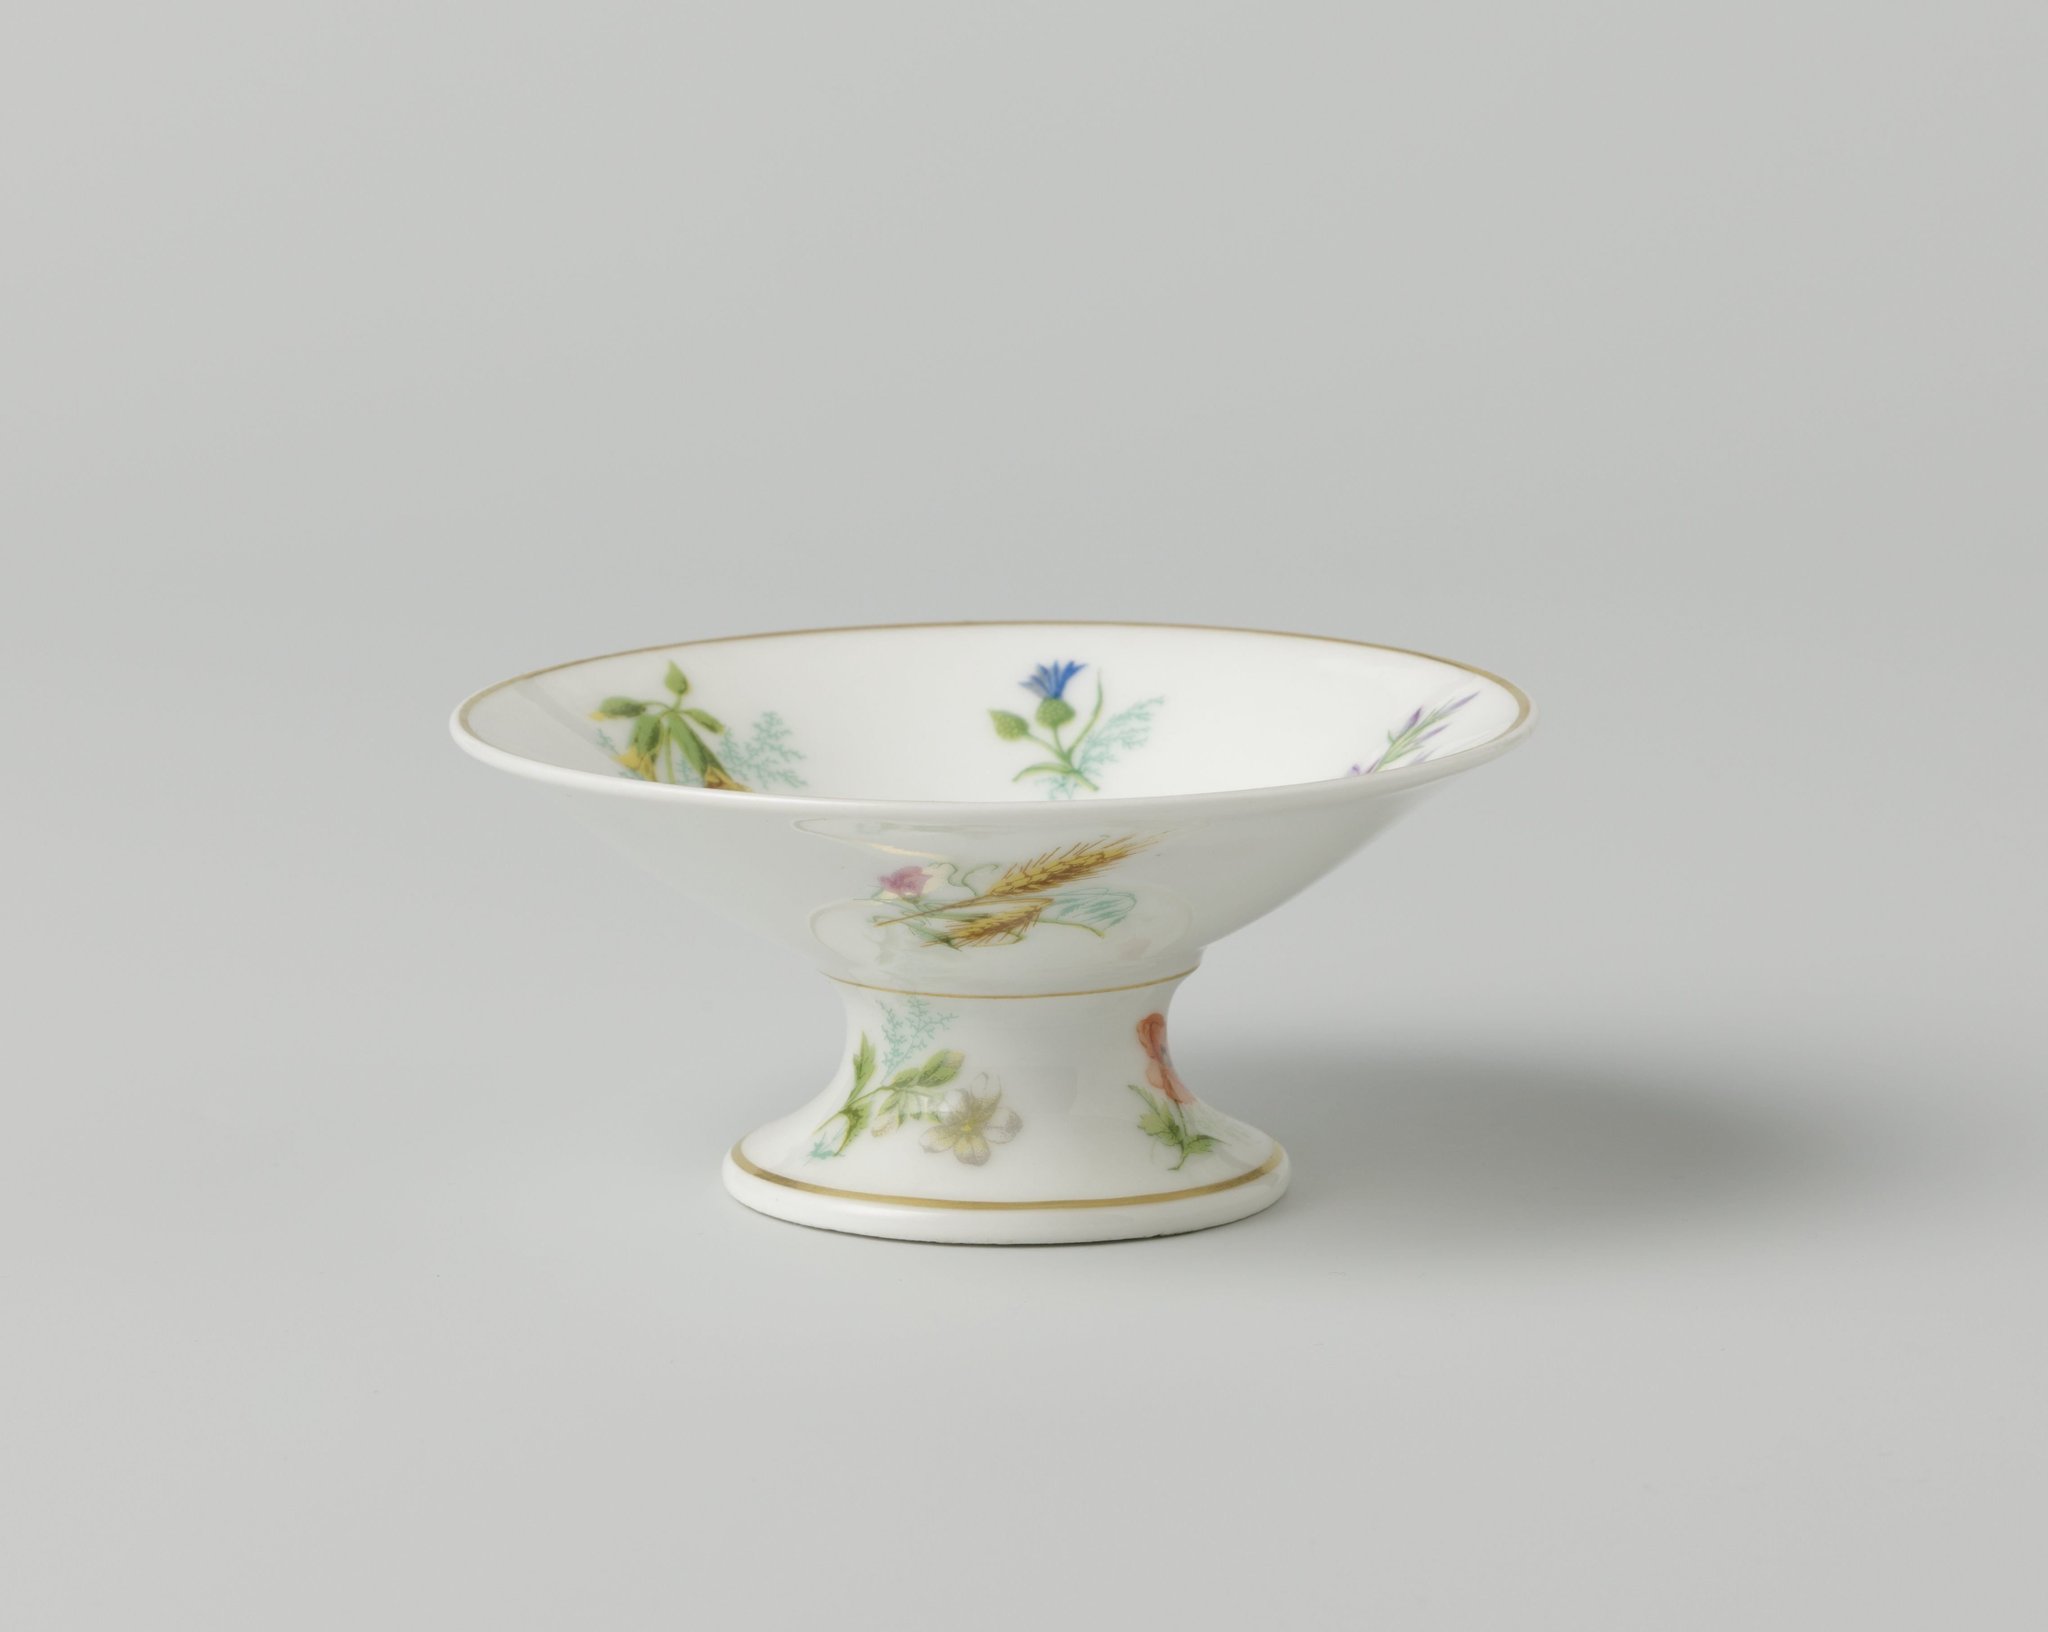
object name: kinderservies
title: Dish on foot with various flower sprays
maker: Anonymous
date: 1850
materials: glaze, gold, paint, porcelain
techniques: firing, forming, gilding, turning, vitrification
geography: france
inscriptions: mark: ‘V’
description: Schaal op voet van porselein, versierd op het glazuur met blauw, rood, roze, groen, geel, paars en goud. De binnen- en buitenzijde van de schaal met verschillende bloemtakken en gouden lijnen op de rand en voet. Gemerkt op de onderzijde met V.